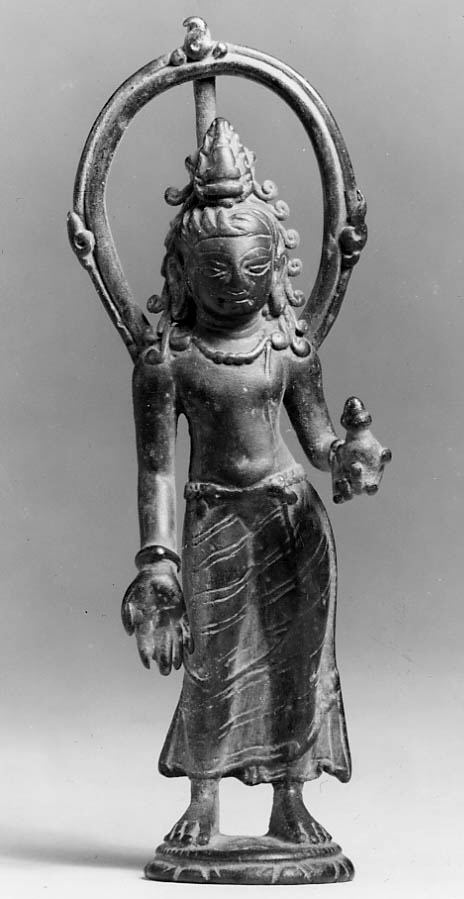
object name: figure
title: Standing Maitreya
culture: indian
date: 601-700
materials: bronze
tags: post-gupta,buddhism,maitreya